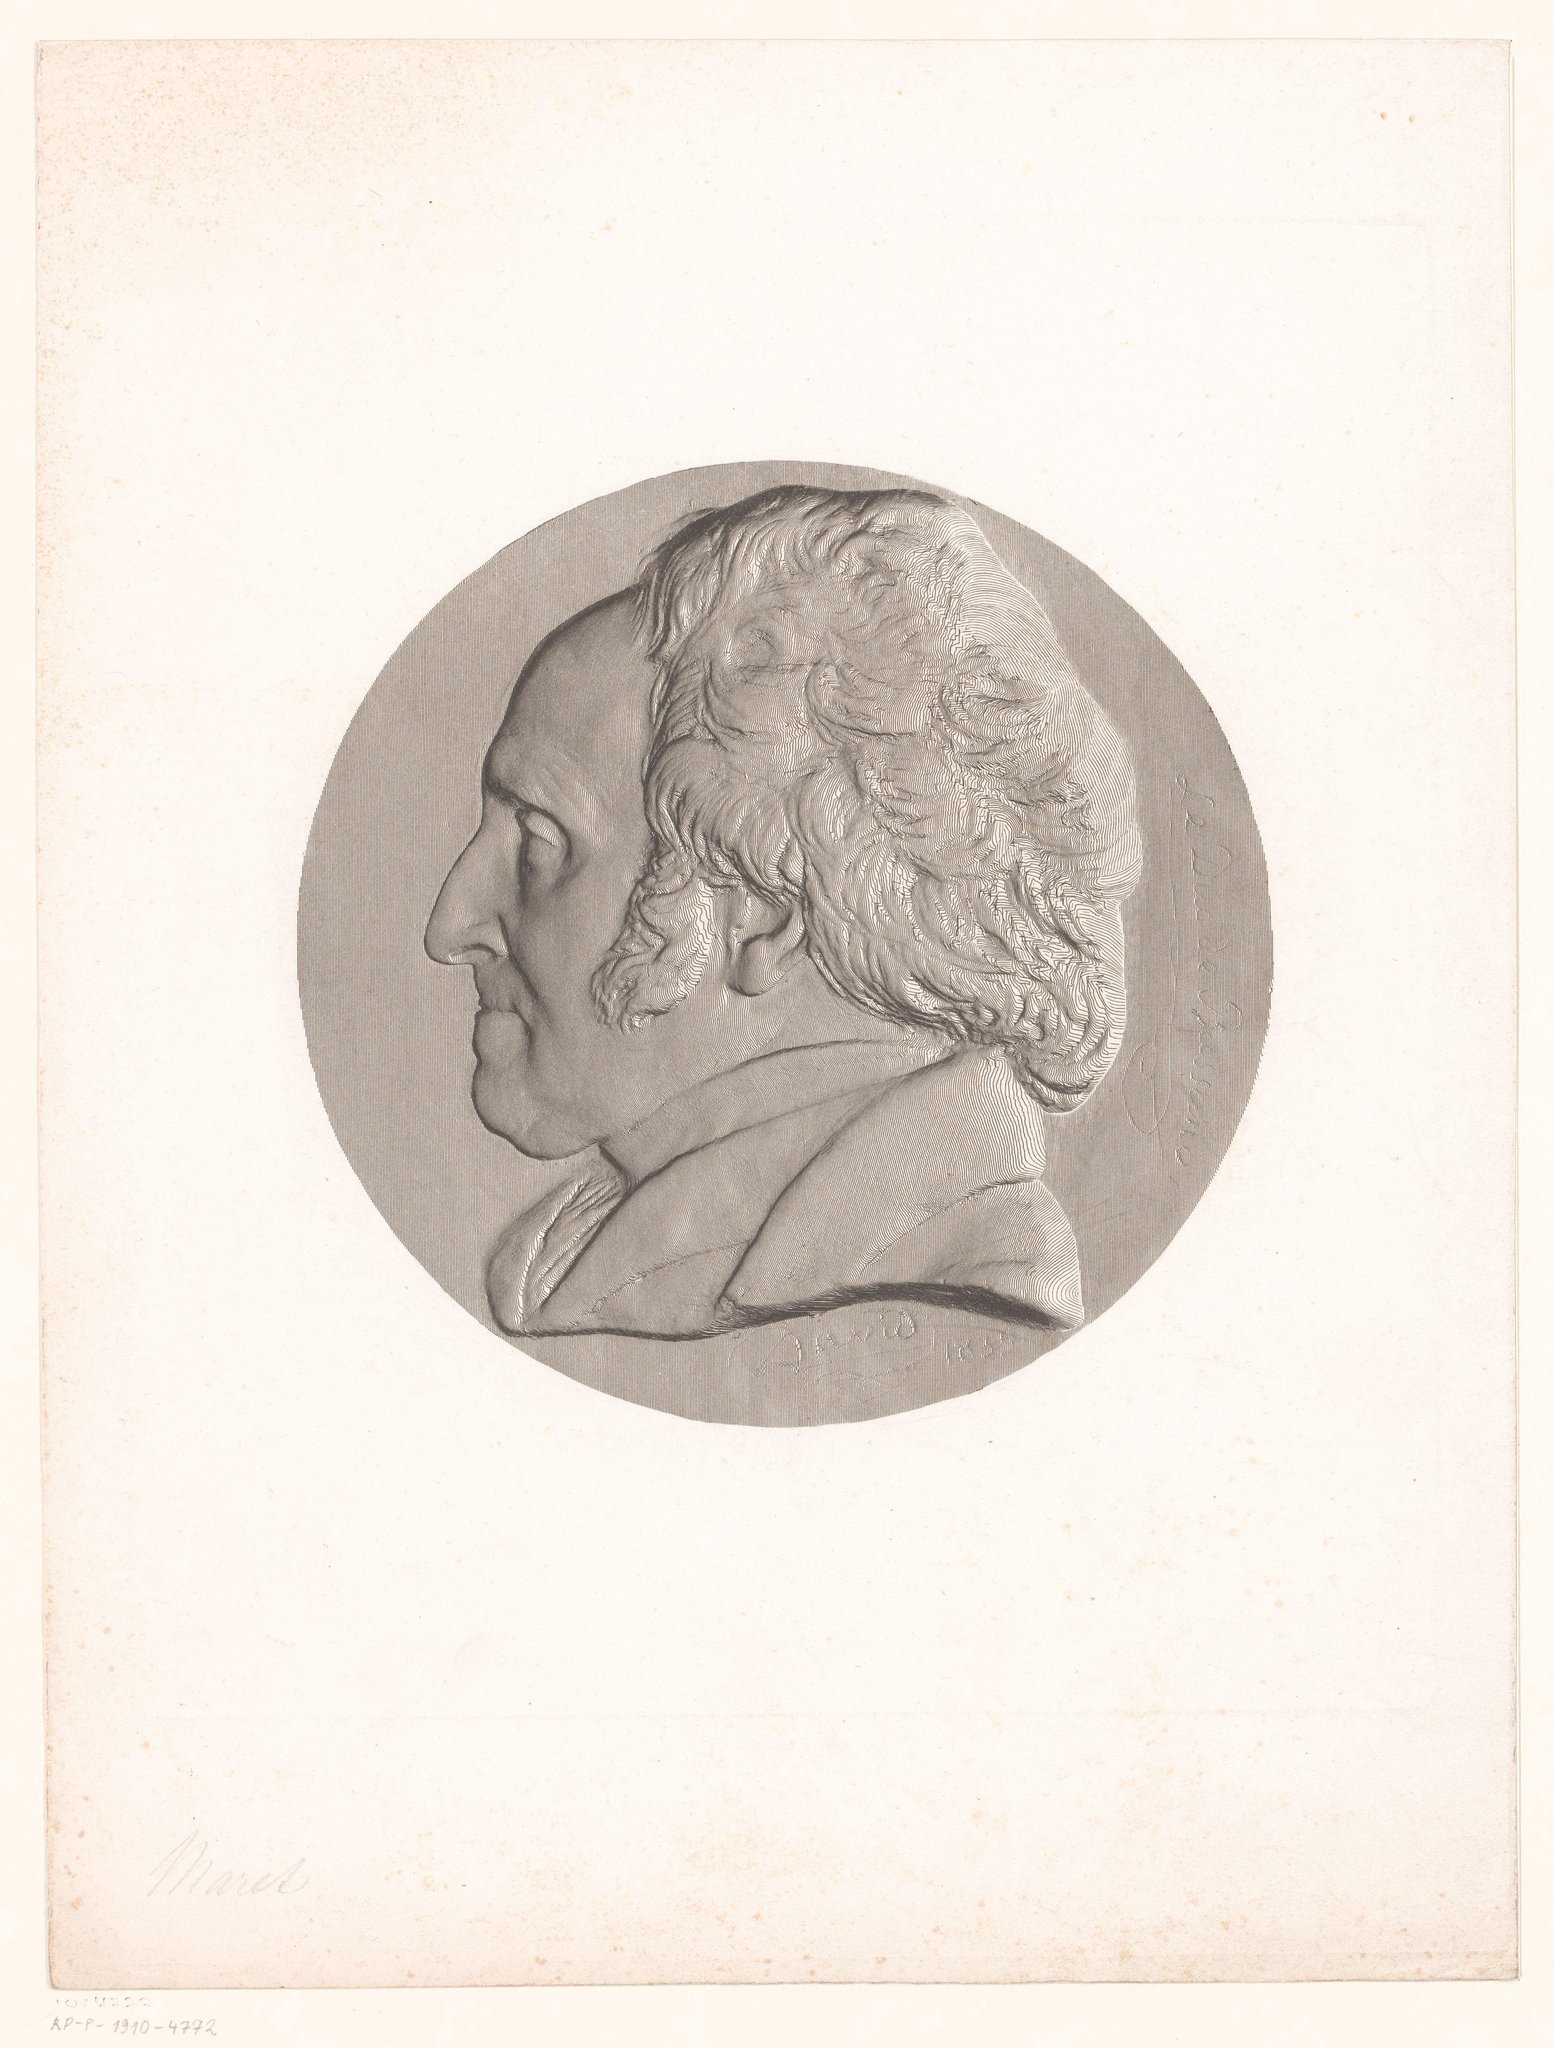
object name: print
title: Le Duc de Bassano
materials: paper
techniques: relief engraving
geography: france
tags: ornament ~ medallion, historical persons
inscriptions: collector's mark: Lugt 2228